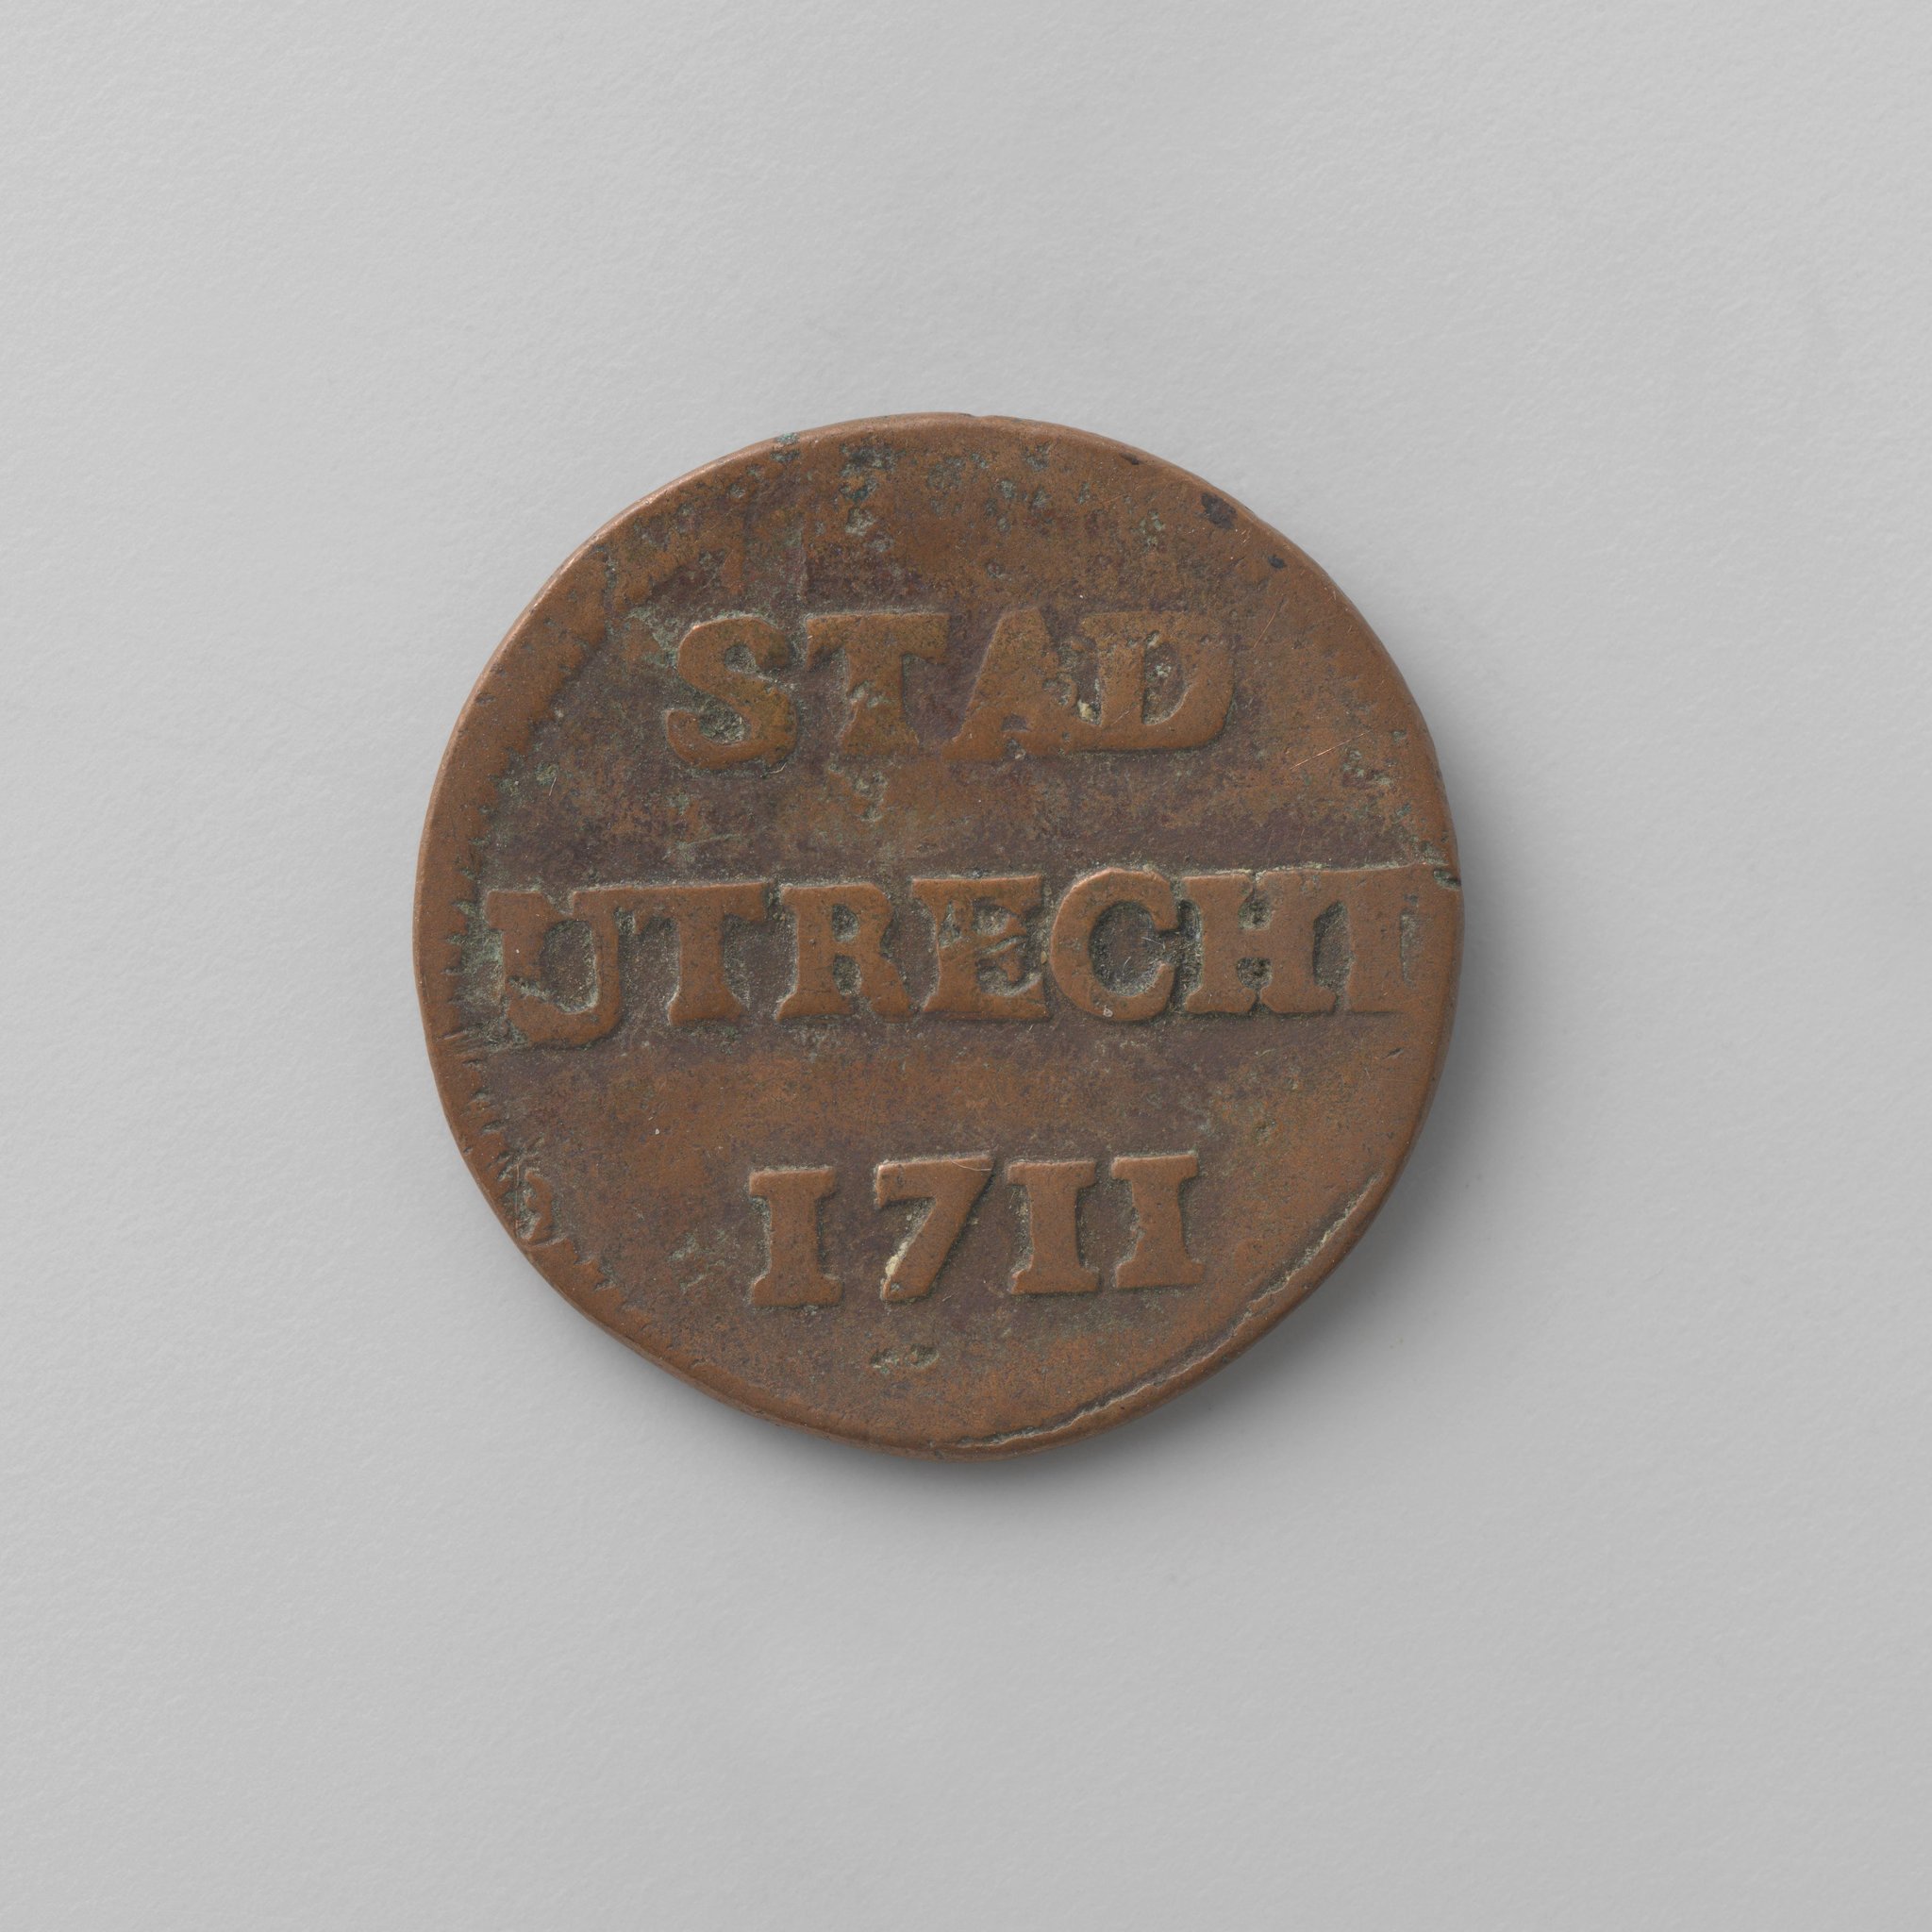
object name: coin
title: Duit van de stad Utrecht, 1711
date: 1711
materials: copper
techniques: striking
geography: utrecht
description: Koperen munt. Voorzijde: gekroond stedelijk wapenschild. Keerzijde: opschrift in twee regels, waaronder jaartal.